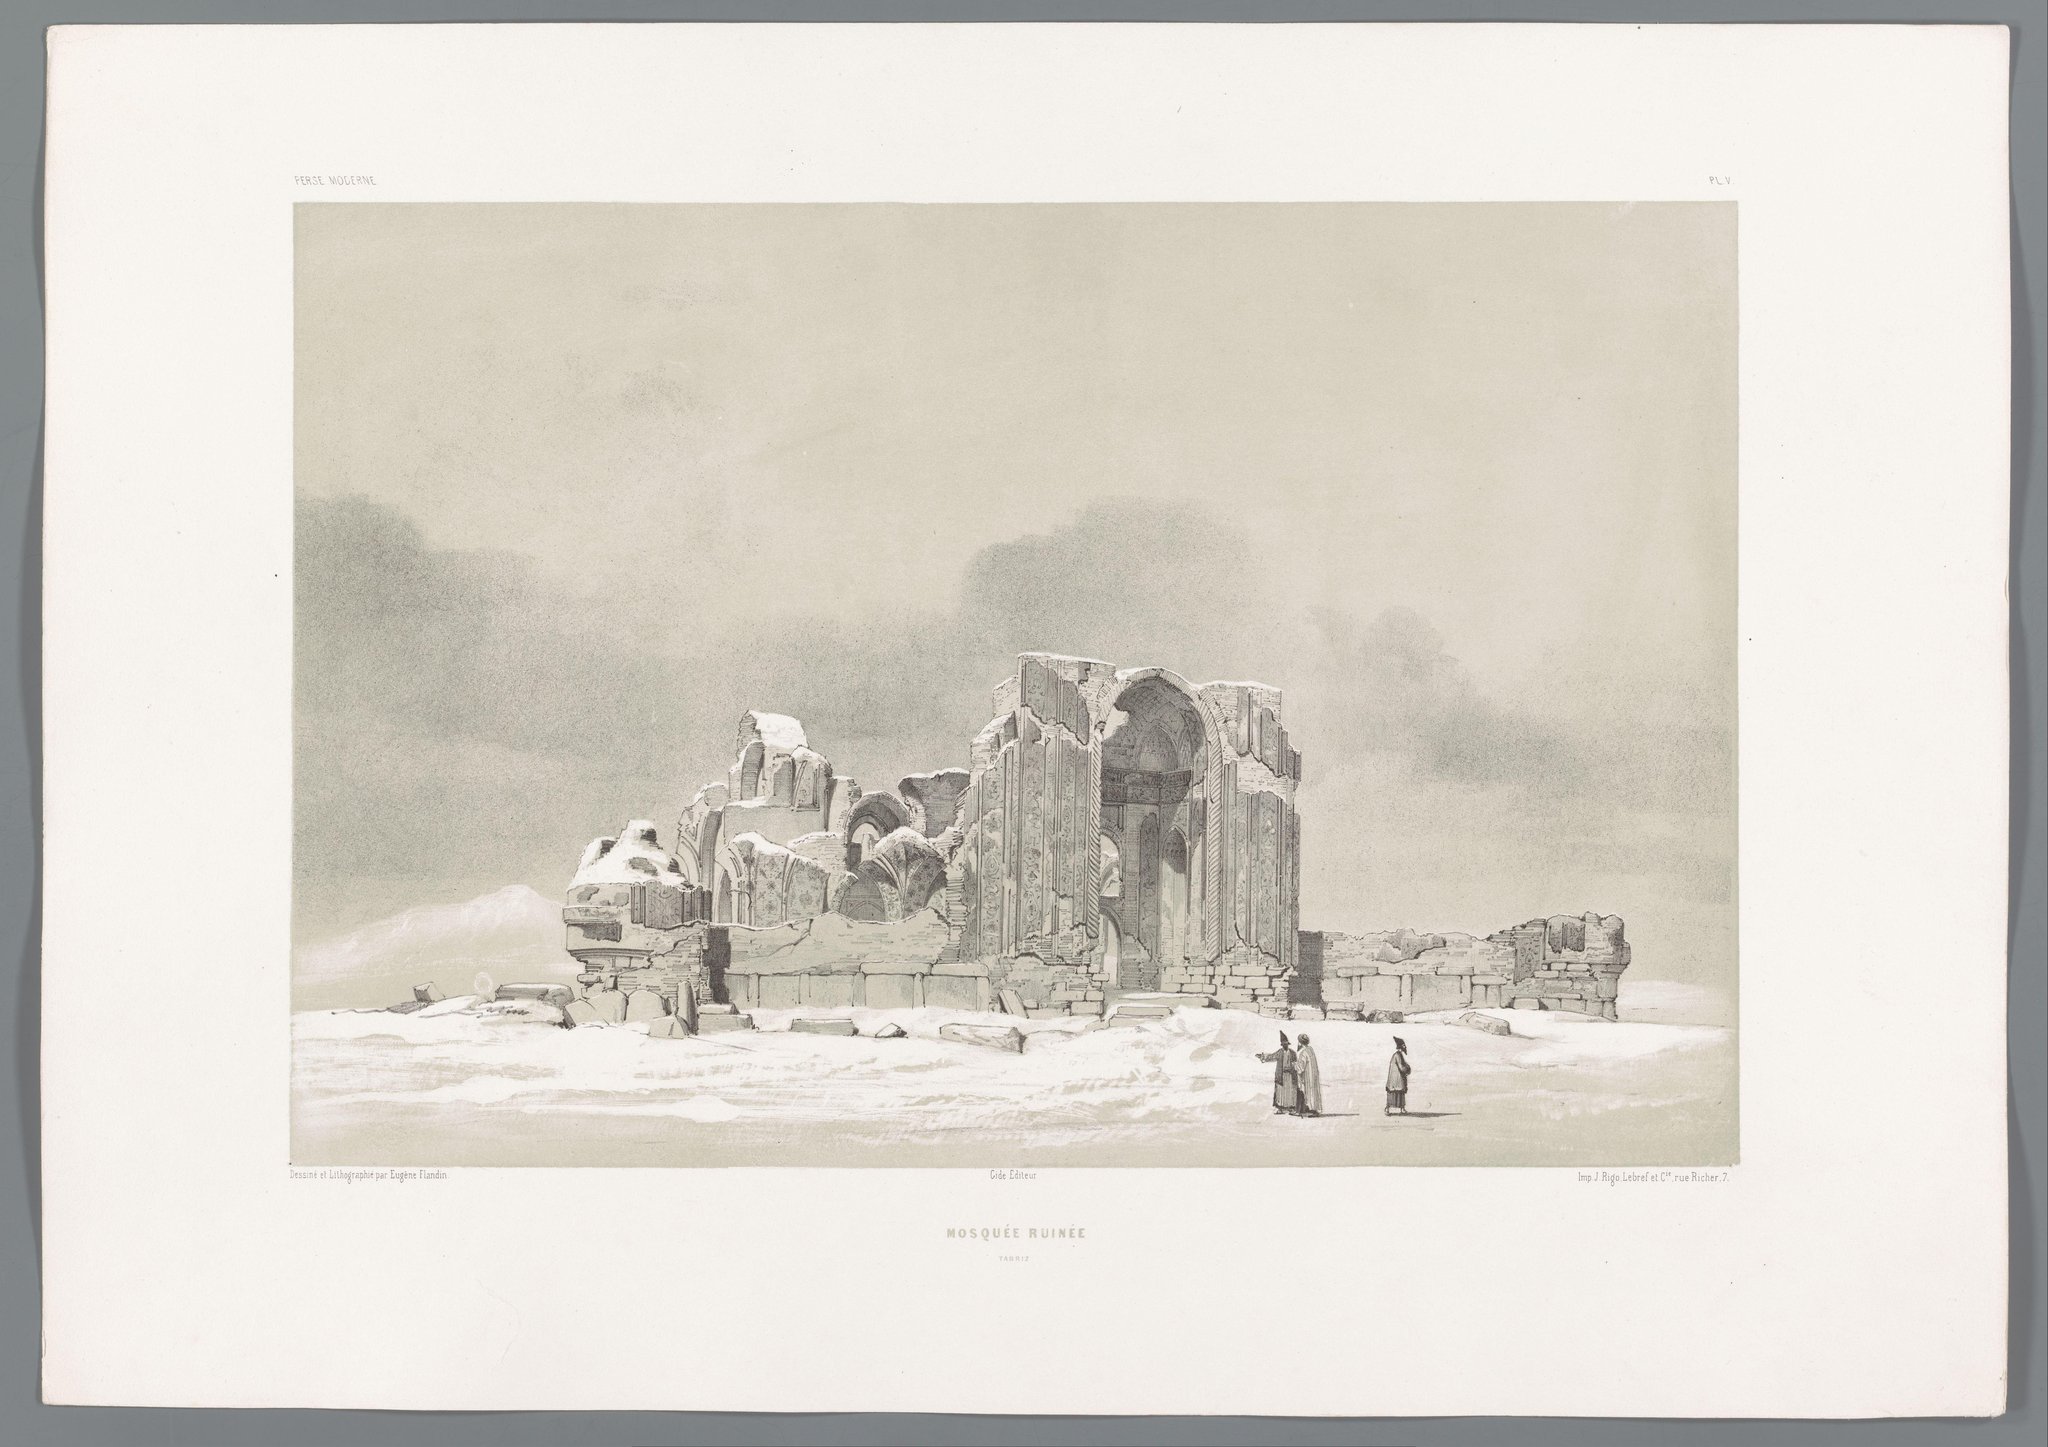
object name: book illustration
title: Ruïne van de Blauwe moskee van Tabriz in Iran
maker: eugène flandin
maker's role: painter, print maker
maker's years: 1809-1889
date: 1843-1854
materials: paper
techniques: tone lithography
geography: paris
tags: landscape with ruins, temple, shrine ~ islam, mohammedanism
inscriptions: collector's mark: Lugt 2760, collector's mark: Lugt 2228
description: Prent uit: Coste, Pascal-Xavier en Eugène Napoléon Flandin. Voyage en Perse de mm. Eugène Flandin, peintre, et Pascal Coste, architecte (...). 8 dln. Parijs: Gide et Jules Baudry, 1843-1854.